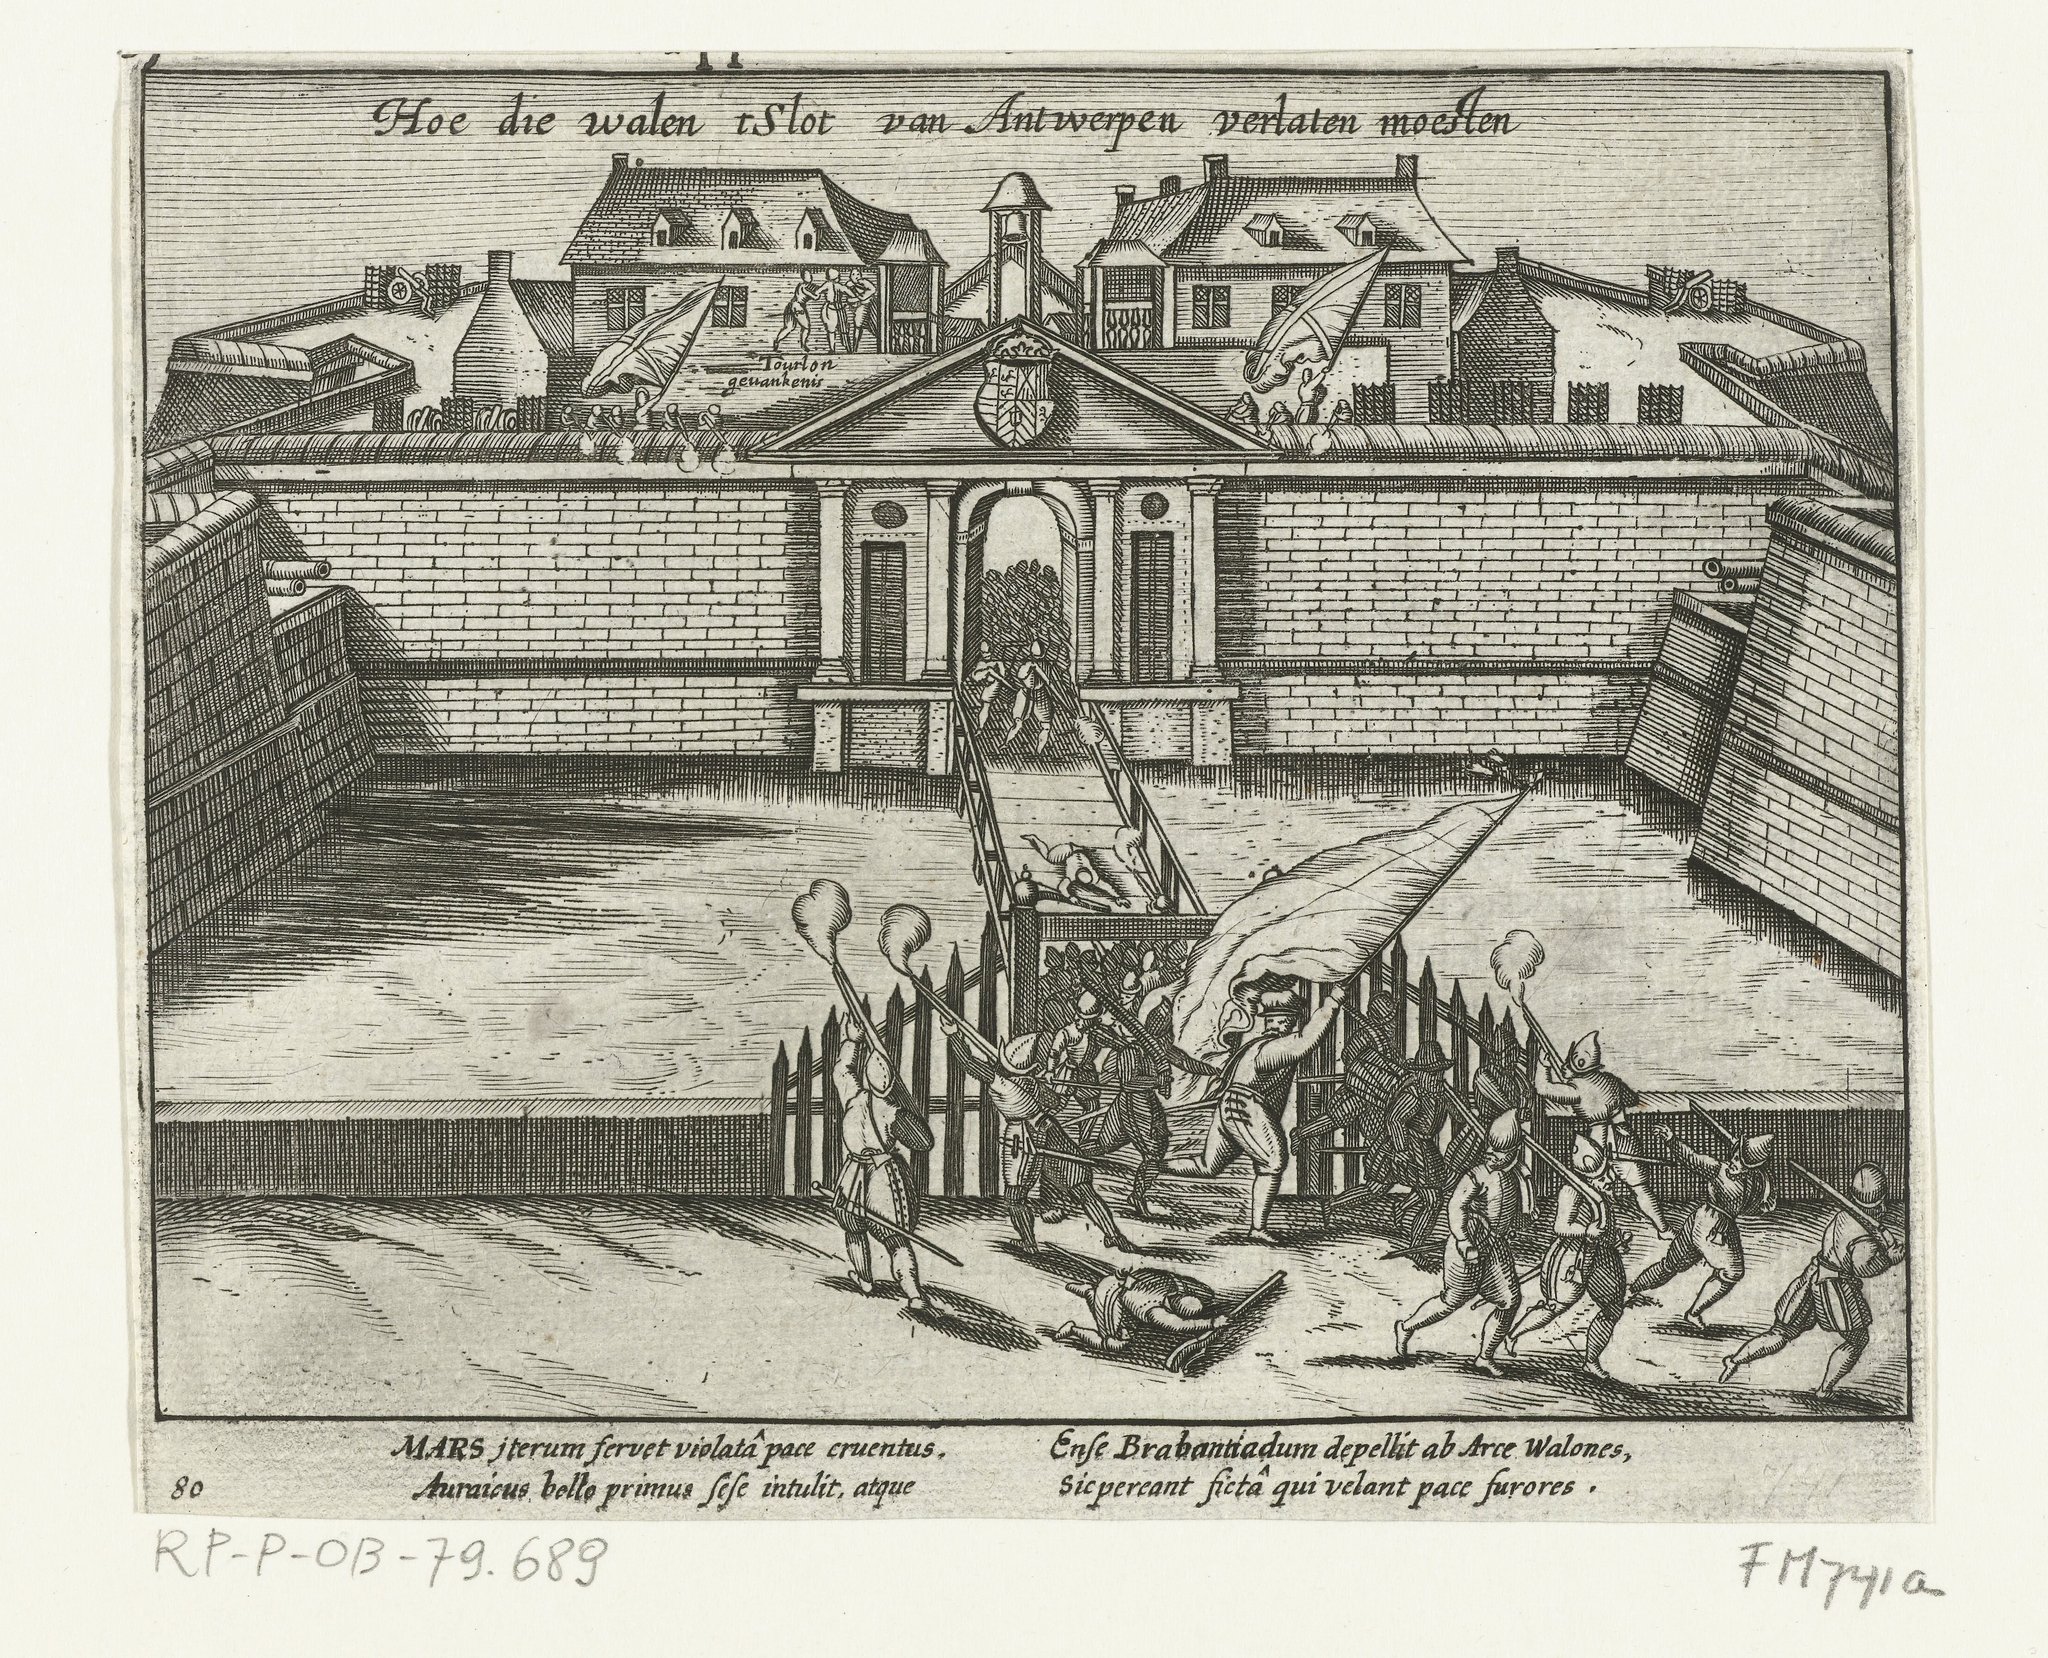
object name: print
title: Walen verlaten de citadel van Antwerpen, 1577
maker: Anonymous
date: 1613-1615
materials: paper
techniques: engraving, etching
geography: northern netherlands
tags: capture of city (after the siege)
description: De Waalse eenheden verlaten de citadel van Antwerpen, 1 augustus 1577. De militaire gouverneur Blois van Treslong wordt gevangengenomen. Met onderschrift van 4 regels in het Latijn. Genummerd: 80. Bedrukt op achterzijde met tekst in het Latijn.